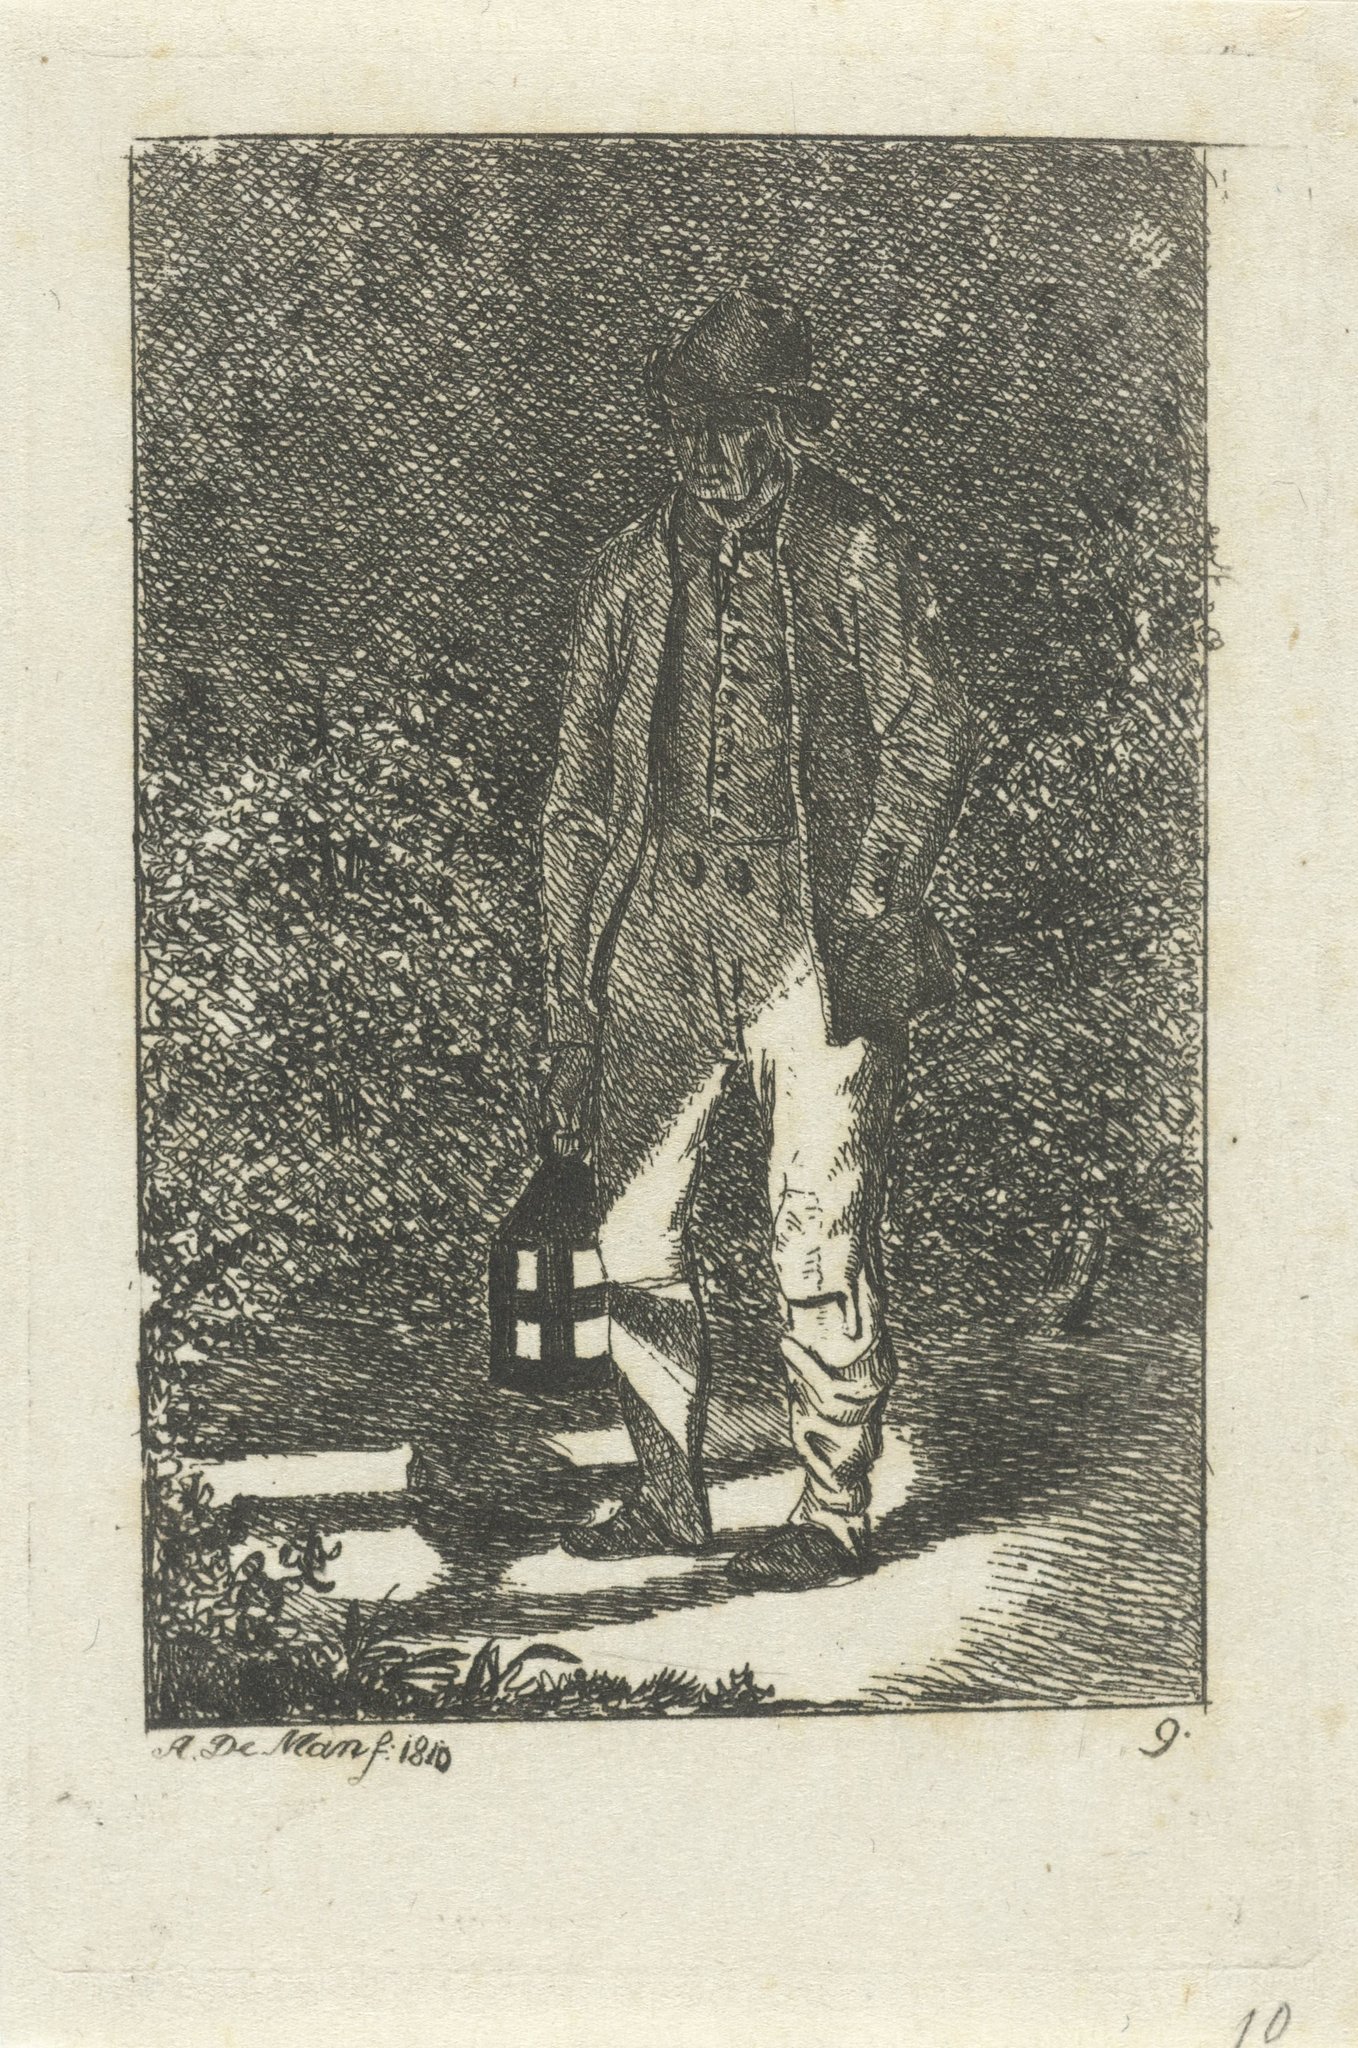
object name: print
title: Man met een lantaarn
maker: anthonie willem hendrik nolthenius de man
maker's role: draughtsman, print maker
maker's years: 1793-1842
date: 1810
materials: paper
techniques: etching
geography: the hague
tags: lantern, night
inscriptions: collector's mark: Lugt 2227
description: Staande man in een tuin, bij nacht, met een lichtgevende lantaarn.